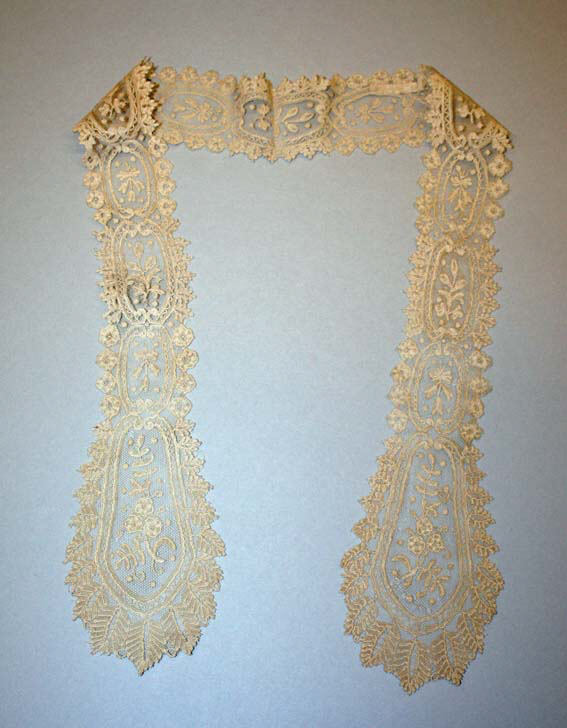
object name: barbe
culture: american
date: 1886